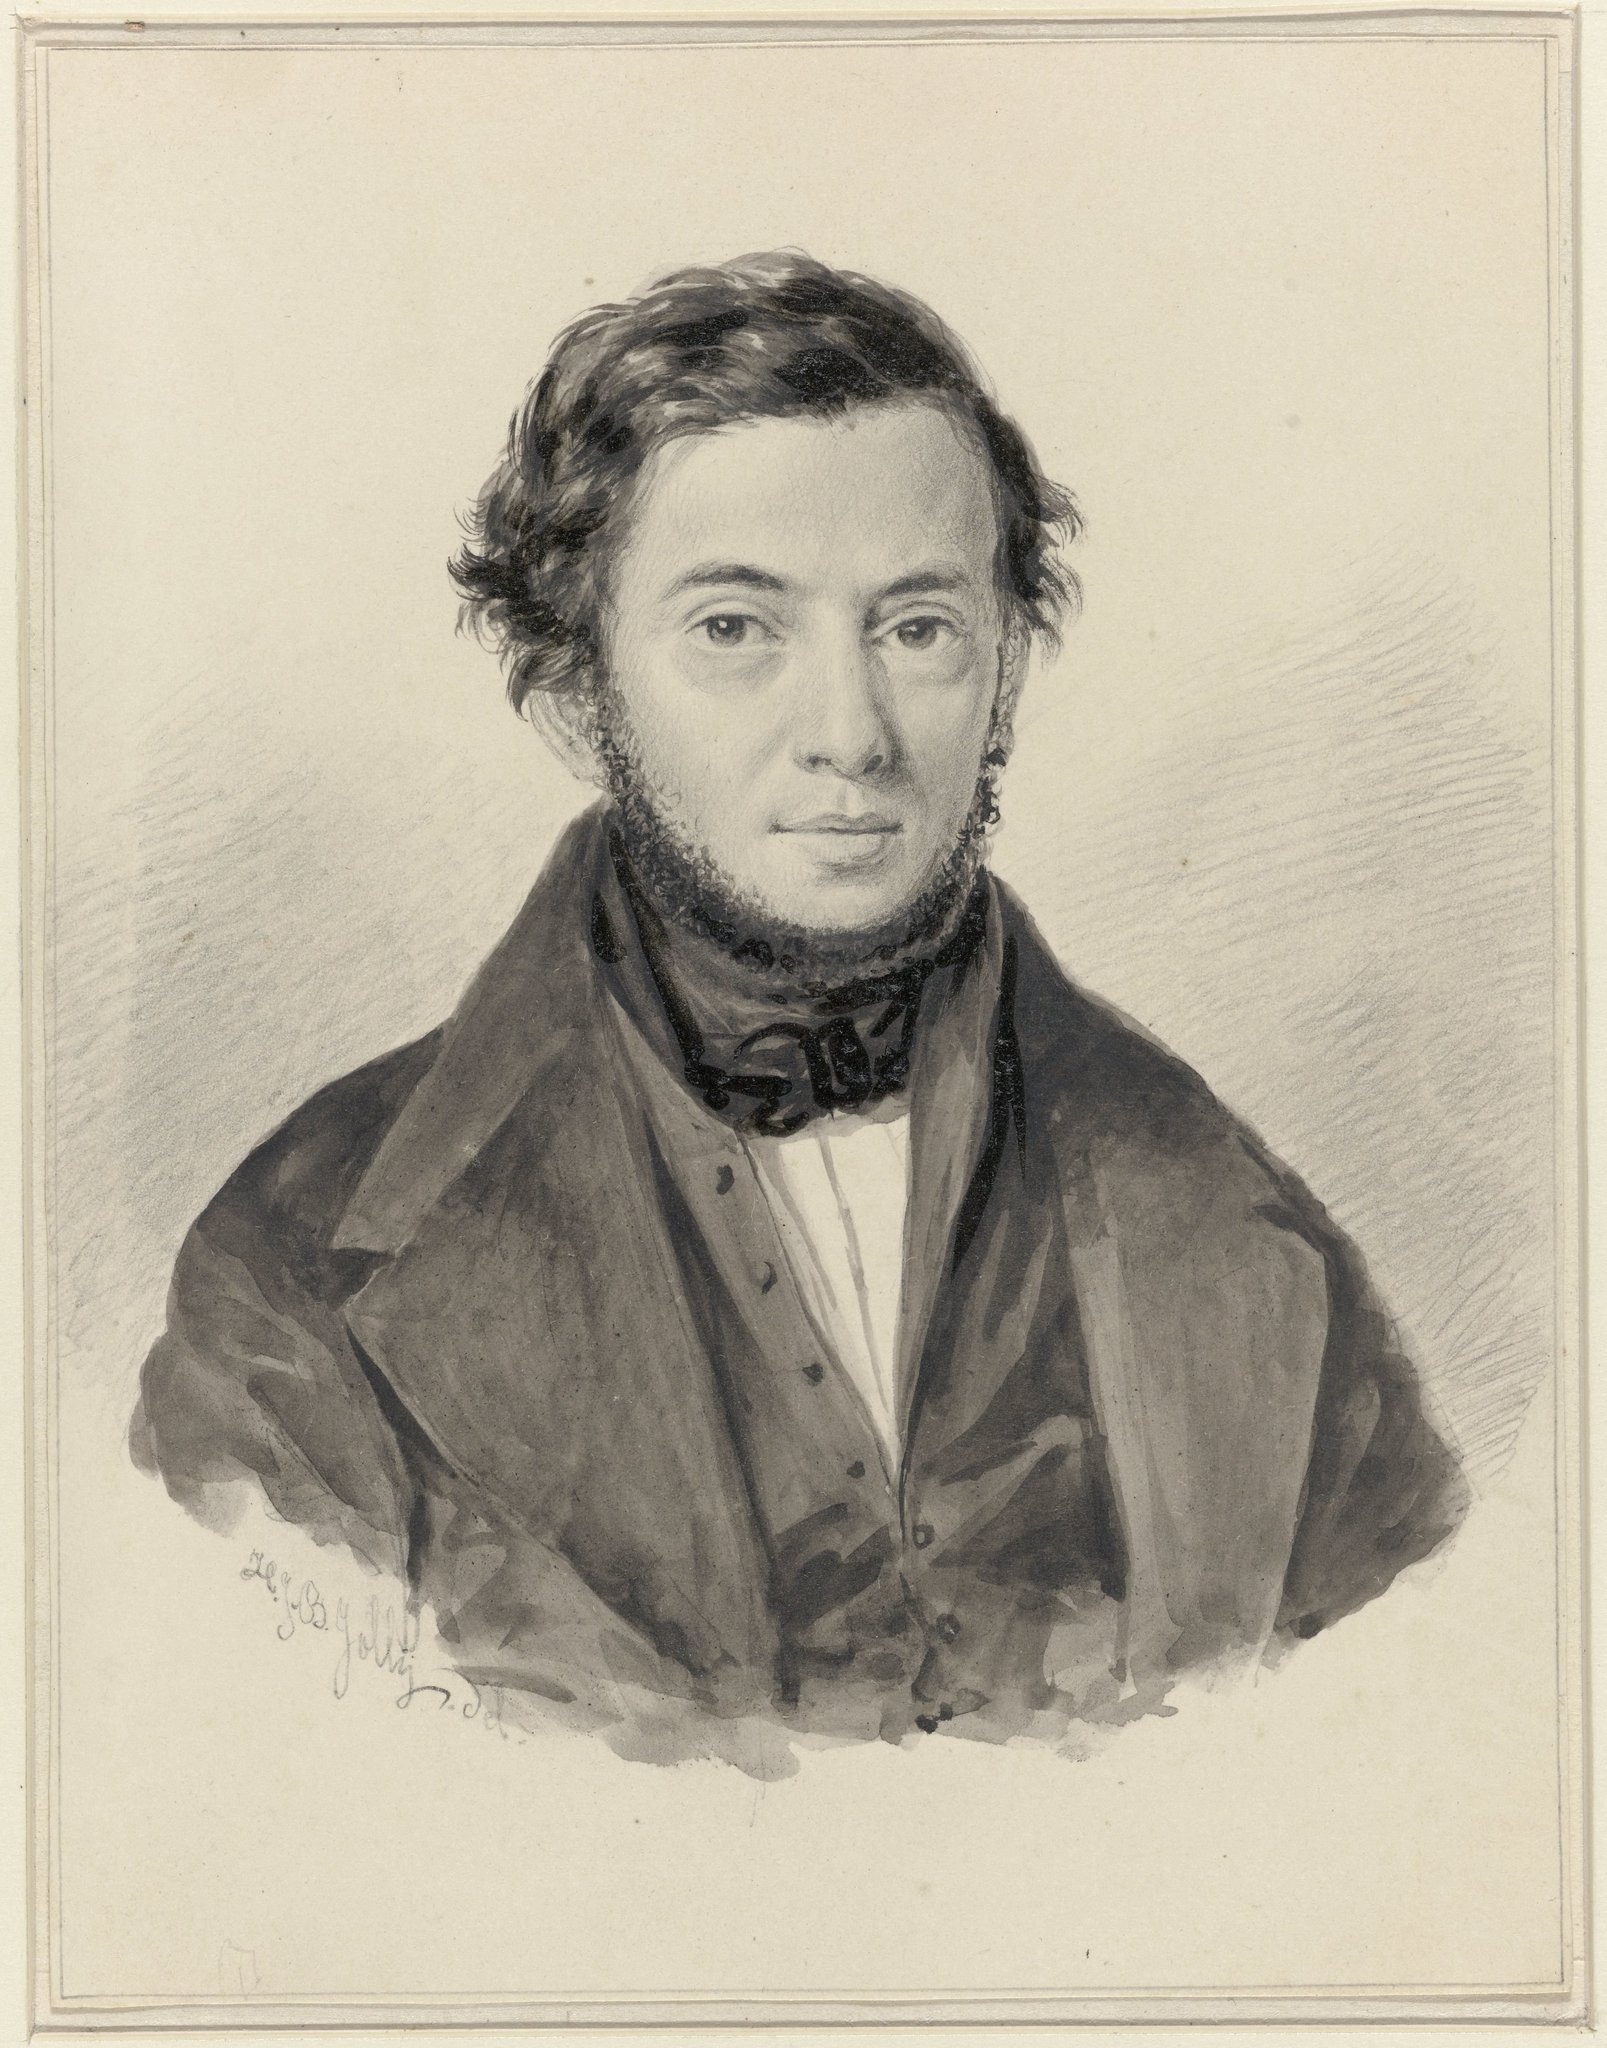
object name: drawing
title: Portret van Jacobus Theodorus Abels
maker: henri jean baptiste jolly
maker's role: draughtsman, painter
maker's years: 1812-1853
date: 1830-1853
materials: paper, pencil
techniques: brush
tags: abcoude, jacobus theodorus abels, historical persons, portrait, self-portrait of painter, portrait, self-portrait of artist